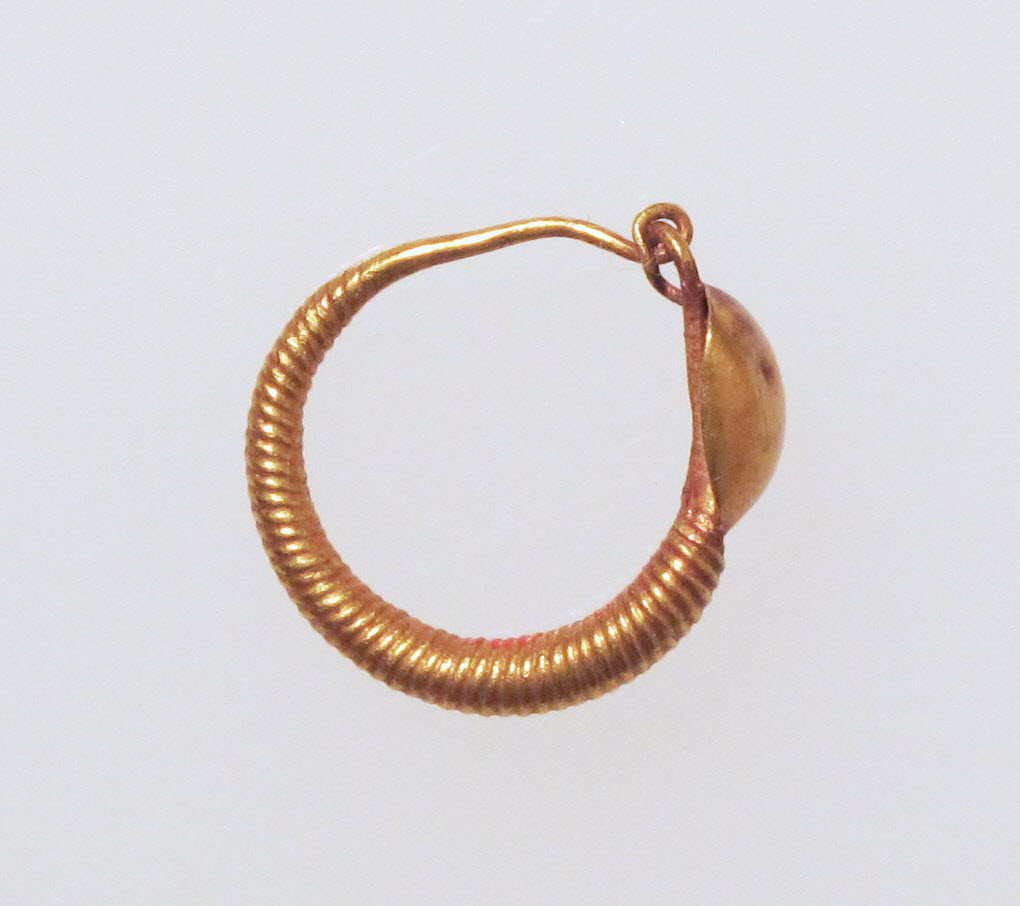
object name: earring with plain loop and disc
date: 7000 BCE-330 CE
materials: gold